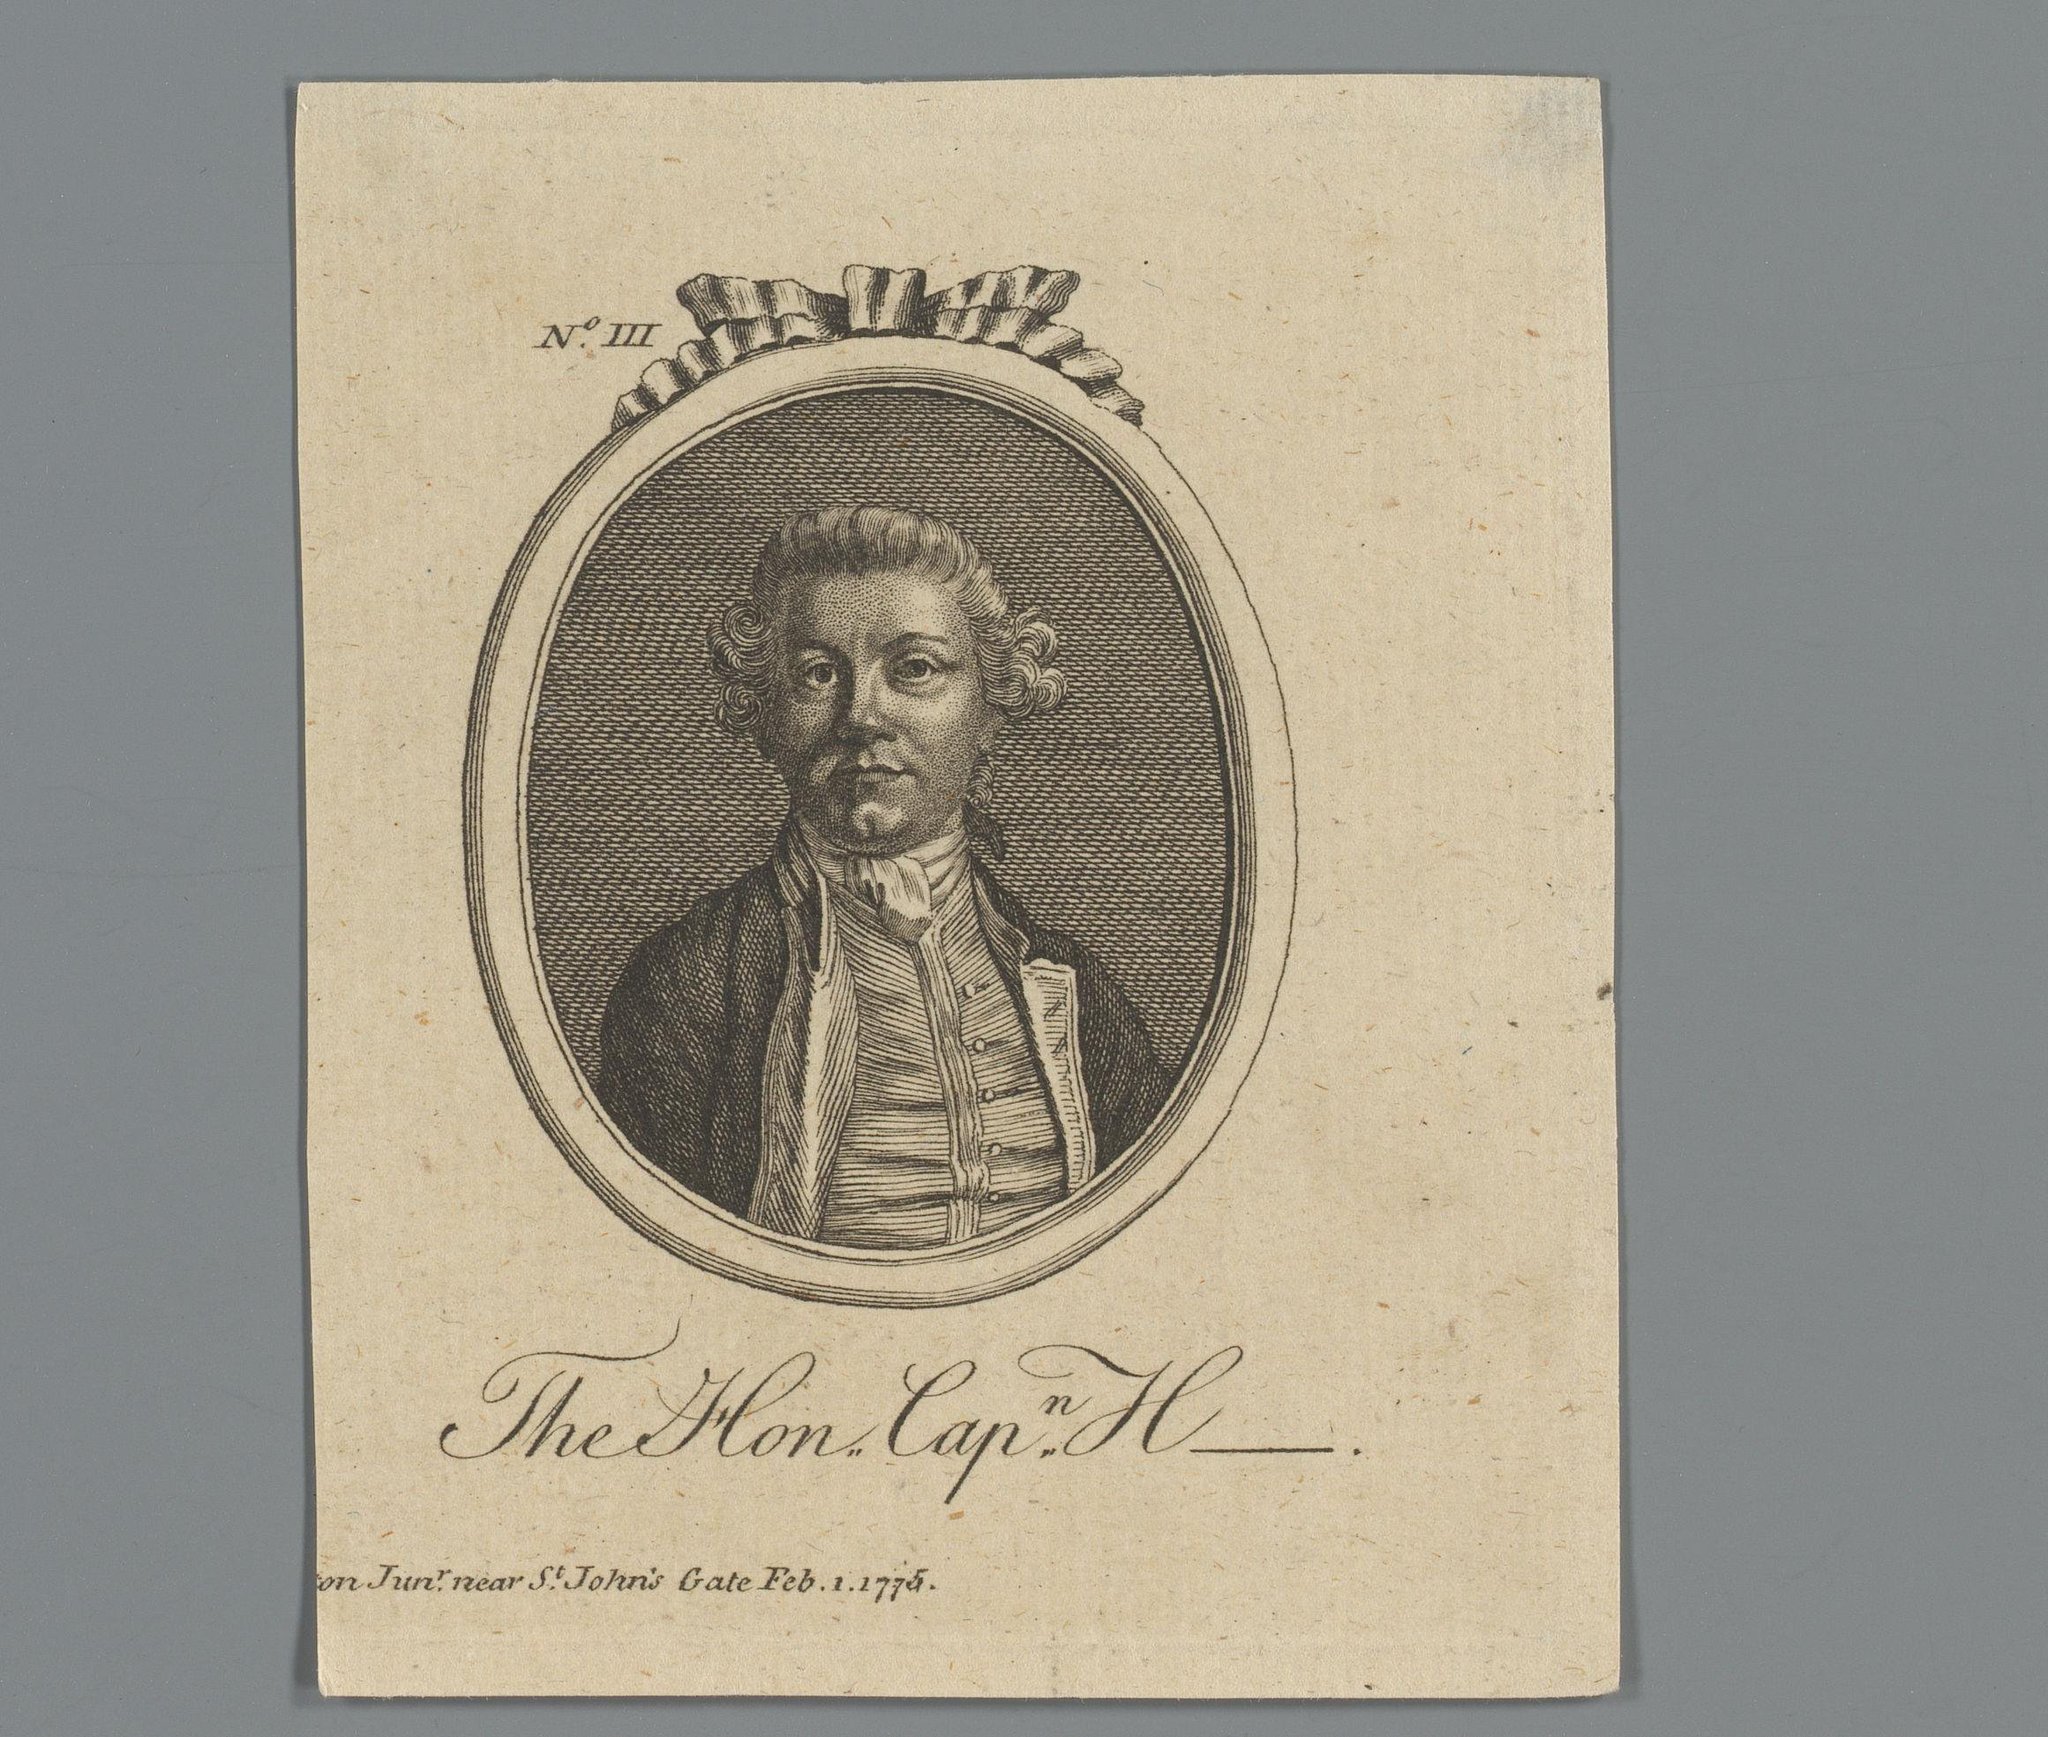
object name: print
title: The Hon Capn H___.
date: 1775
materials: paper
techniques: etching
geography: london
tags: wig, historical persons not known by name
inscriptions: collector's mark: Lugt 2228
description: Prent waarschijnlijk uit: Town and Country Magazine 7 (1775), februari 1775.